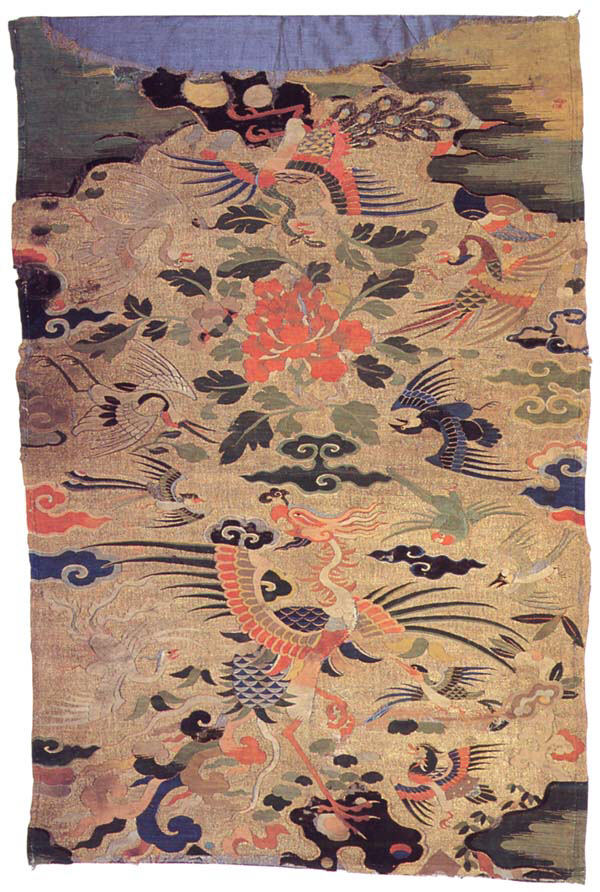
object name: panel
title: Panel (Kesi) with a Phoenix and Other Birds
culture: chinese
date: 1601-1700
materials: feather, gilt, paper, silk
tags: birds,flowers